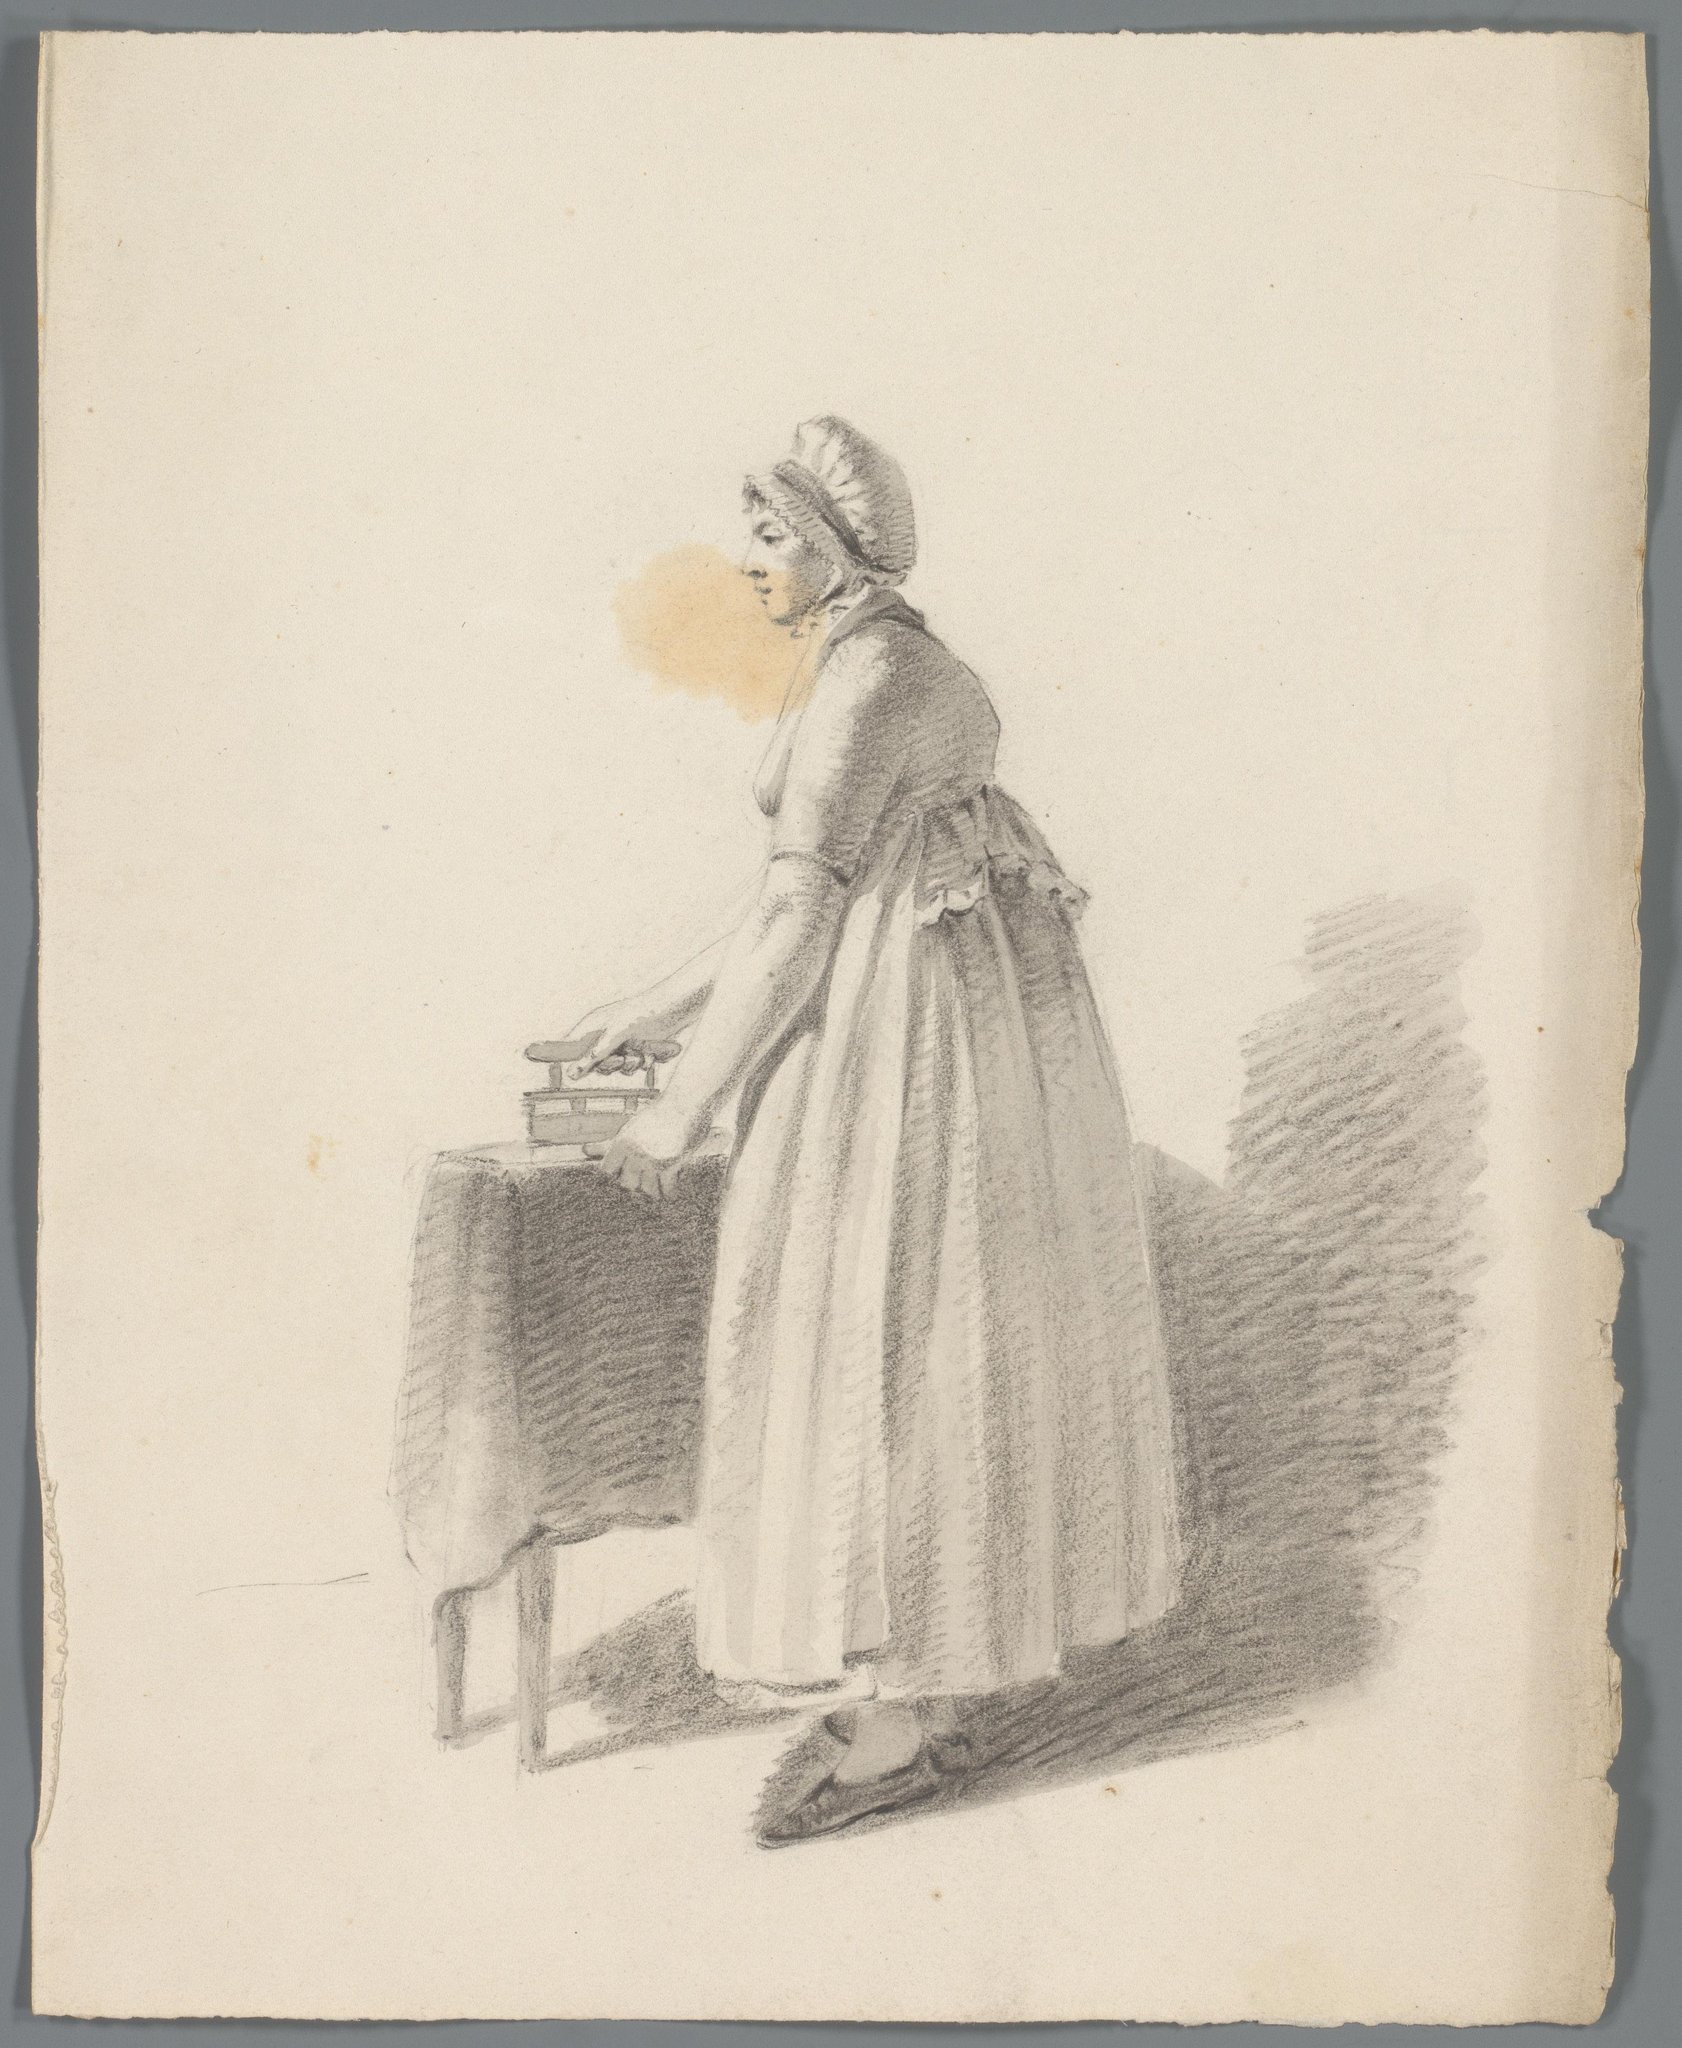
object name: drawing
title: Vrouw aan het strijken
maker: Anonymous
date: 1820-1830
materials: chalk, paper, watercolor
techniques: brush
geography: the hague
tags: ironing, adult woman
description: Tekeningen waarschijnlijk ontstaan bij het Haagse kunstgenootschap ‘Tot Nut der Tekenkunst’, waar twee keer per week tekenavonden werden georganiseerd met geklede modellen.